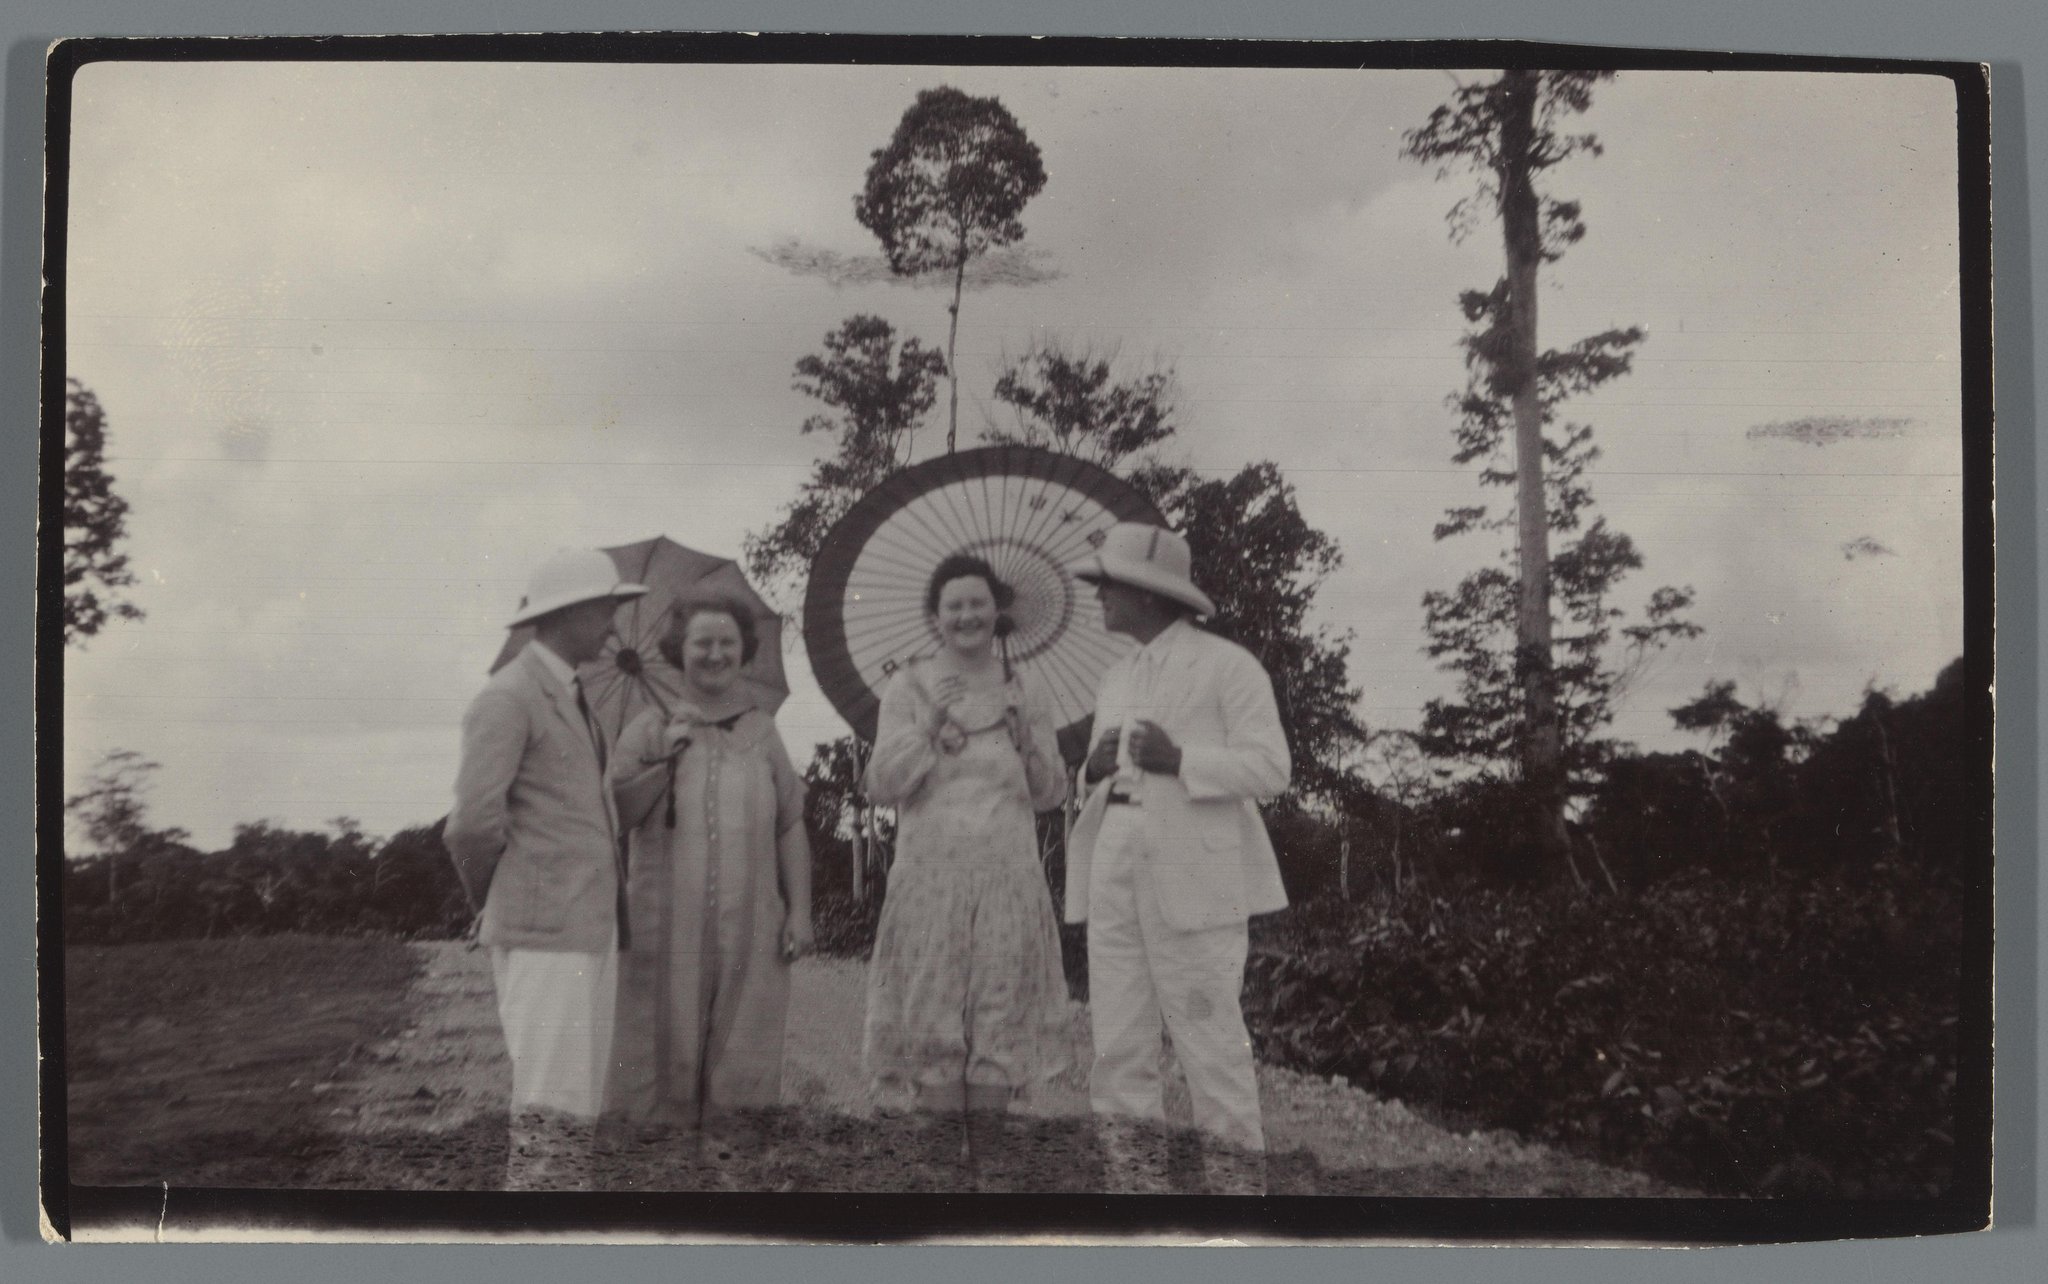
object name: photograph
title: Ingenieur Jetten met echtgenote en ander echtpaar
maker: Anonymous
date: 1925-1927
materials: photographic support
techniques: photography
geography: suriname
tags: jetten, familie, moengo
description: Ingenieur Jetten met zijn echtgenote en een ander echtpaar, de vrouwen met parasols. Onderdeel van het ensemble met foto's van de familie van ingenieur Jetten in de mijnbouwstad Moengo in Suriname.